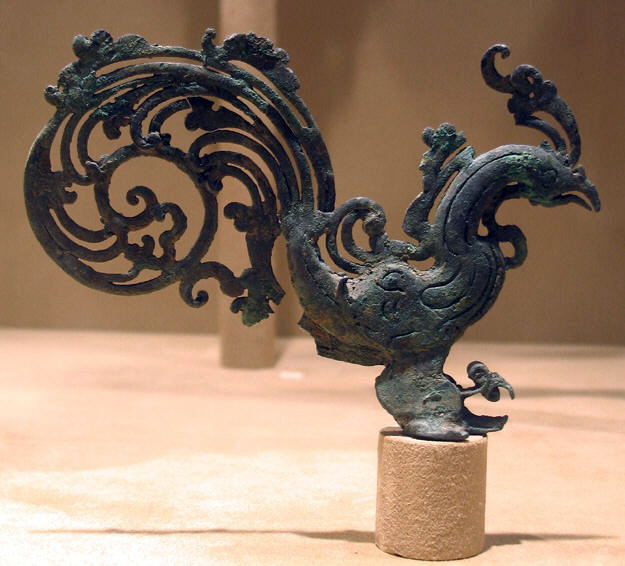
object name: finial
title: Finial with a Cockerel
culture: indonesian, javanese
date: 901-950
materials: bronze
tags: roosters